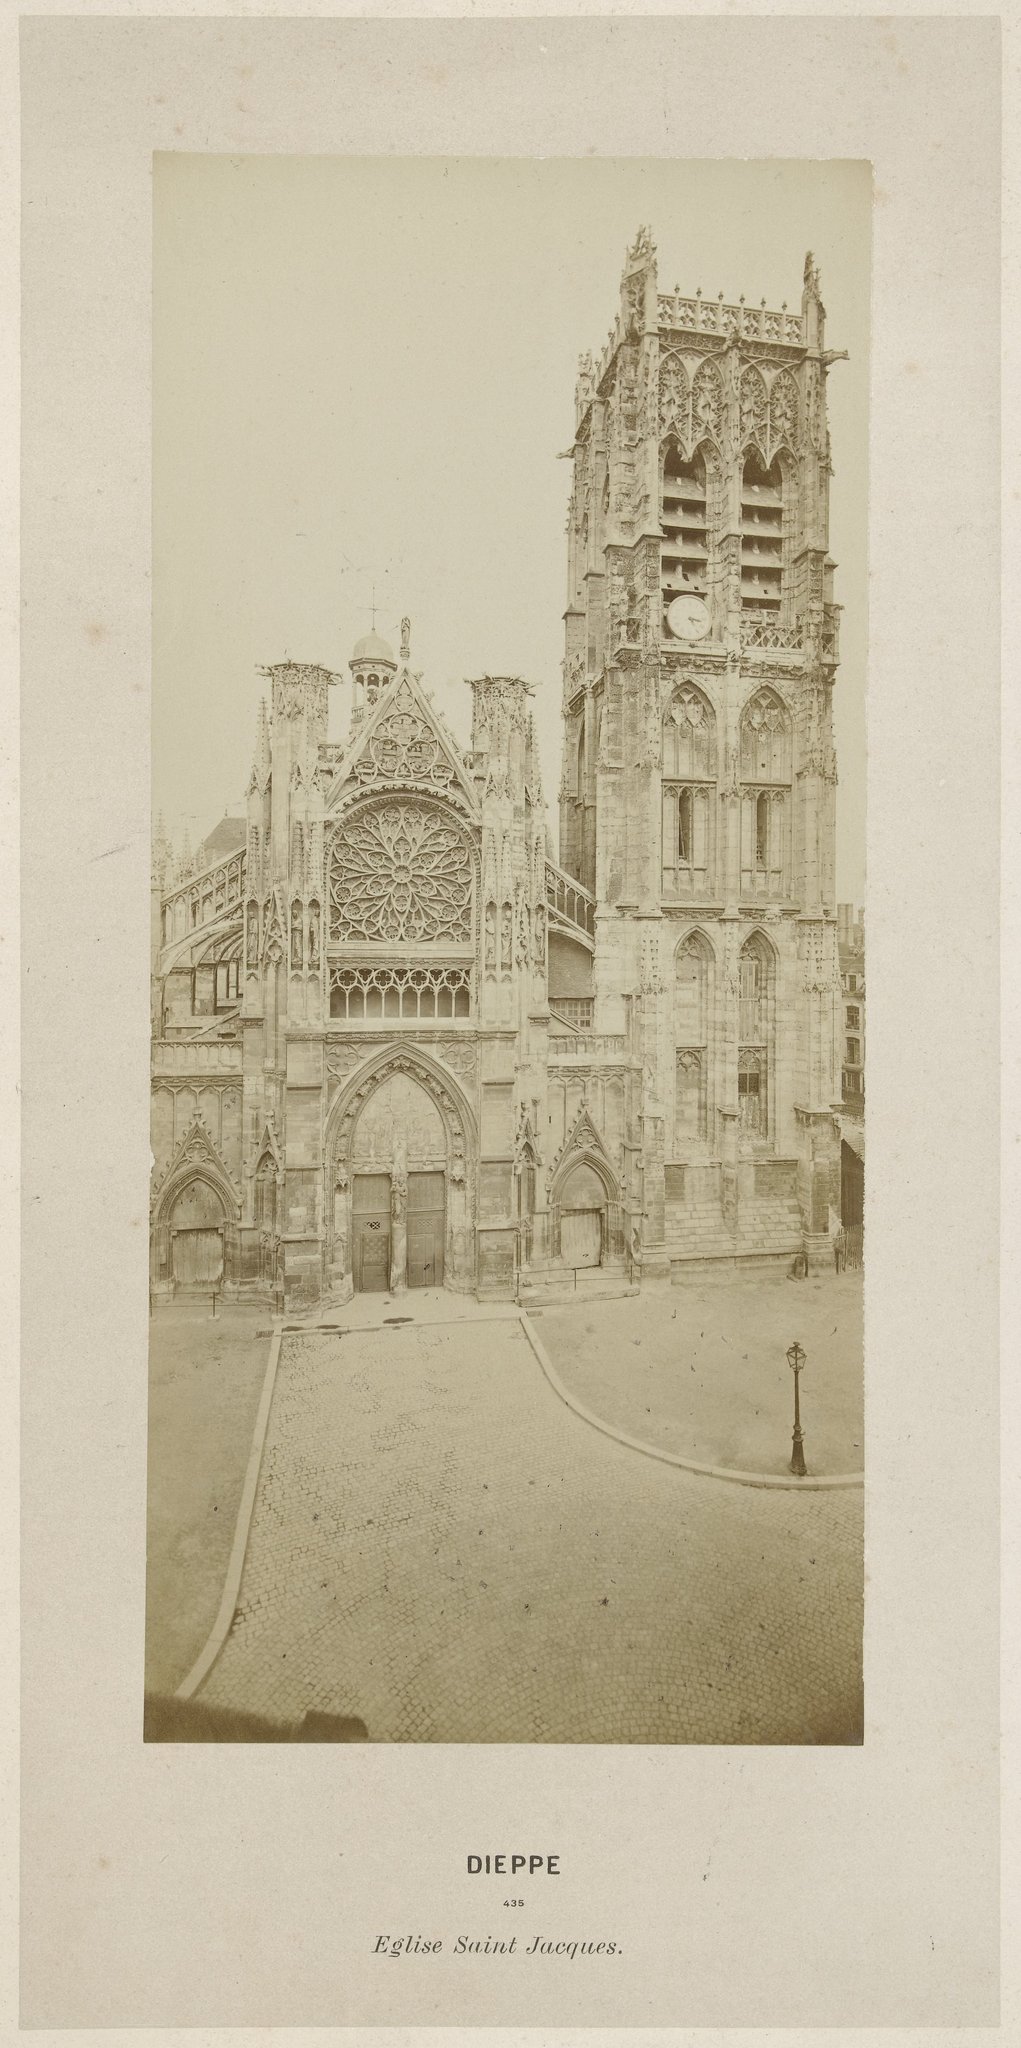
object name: photograph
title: Église Saint-Jacques te Dieppe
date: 1863-1900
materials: cardboard, paper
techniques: albumen print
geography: dieppe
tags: church (exterior)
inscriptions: inscription: ‘uit K.O.G. 1980’, inscription: ‘Dieppe/ 435/ Eglise Saint Jacques.’